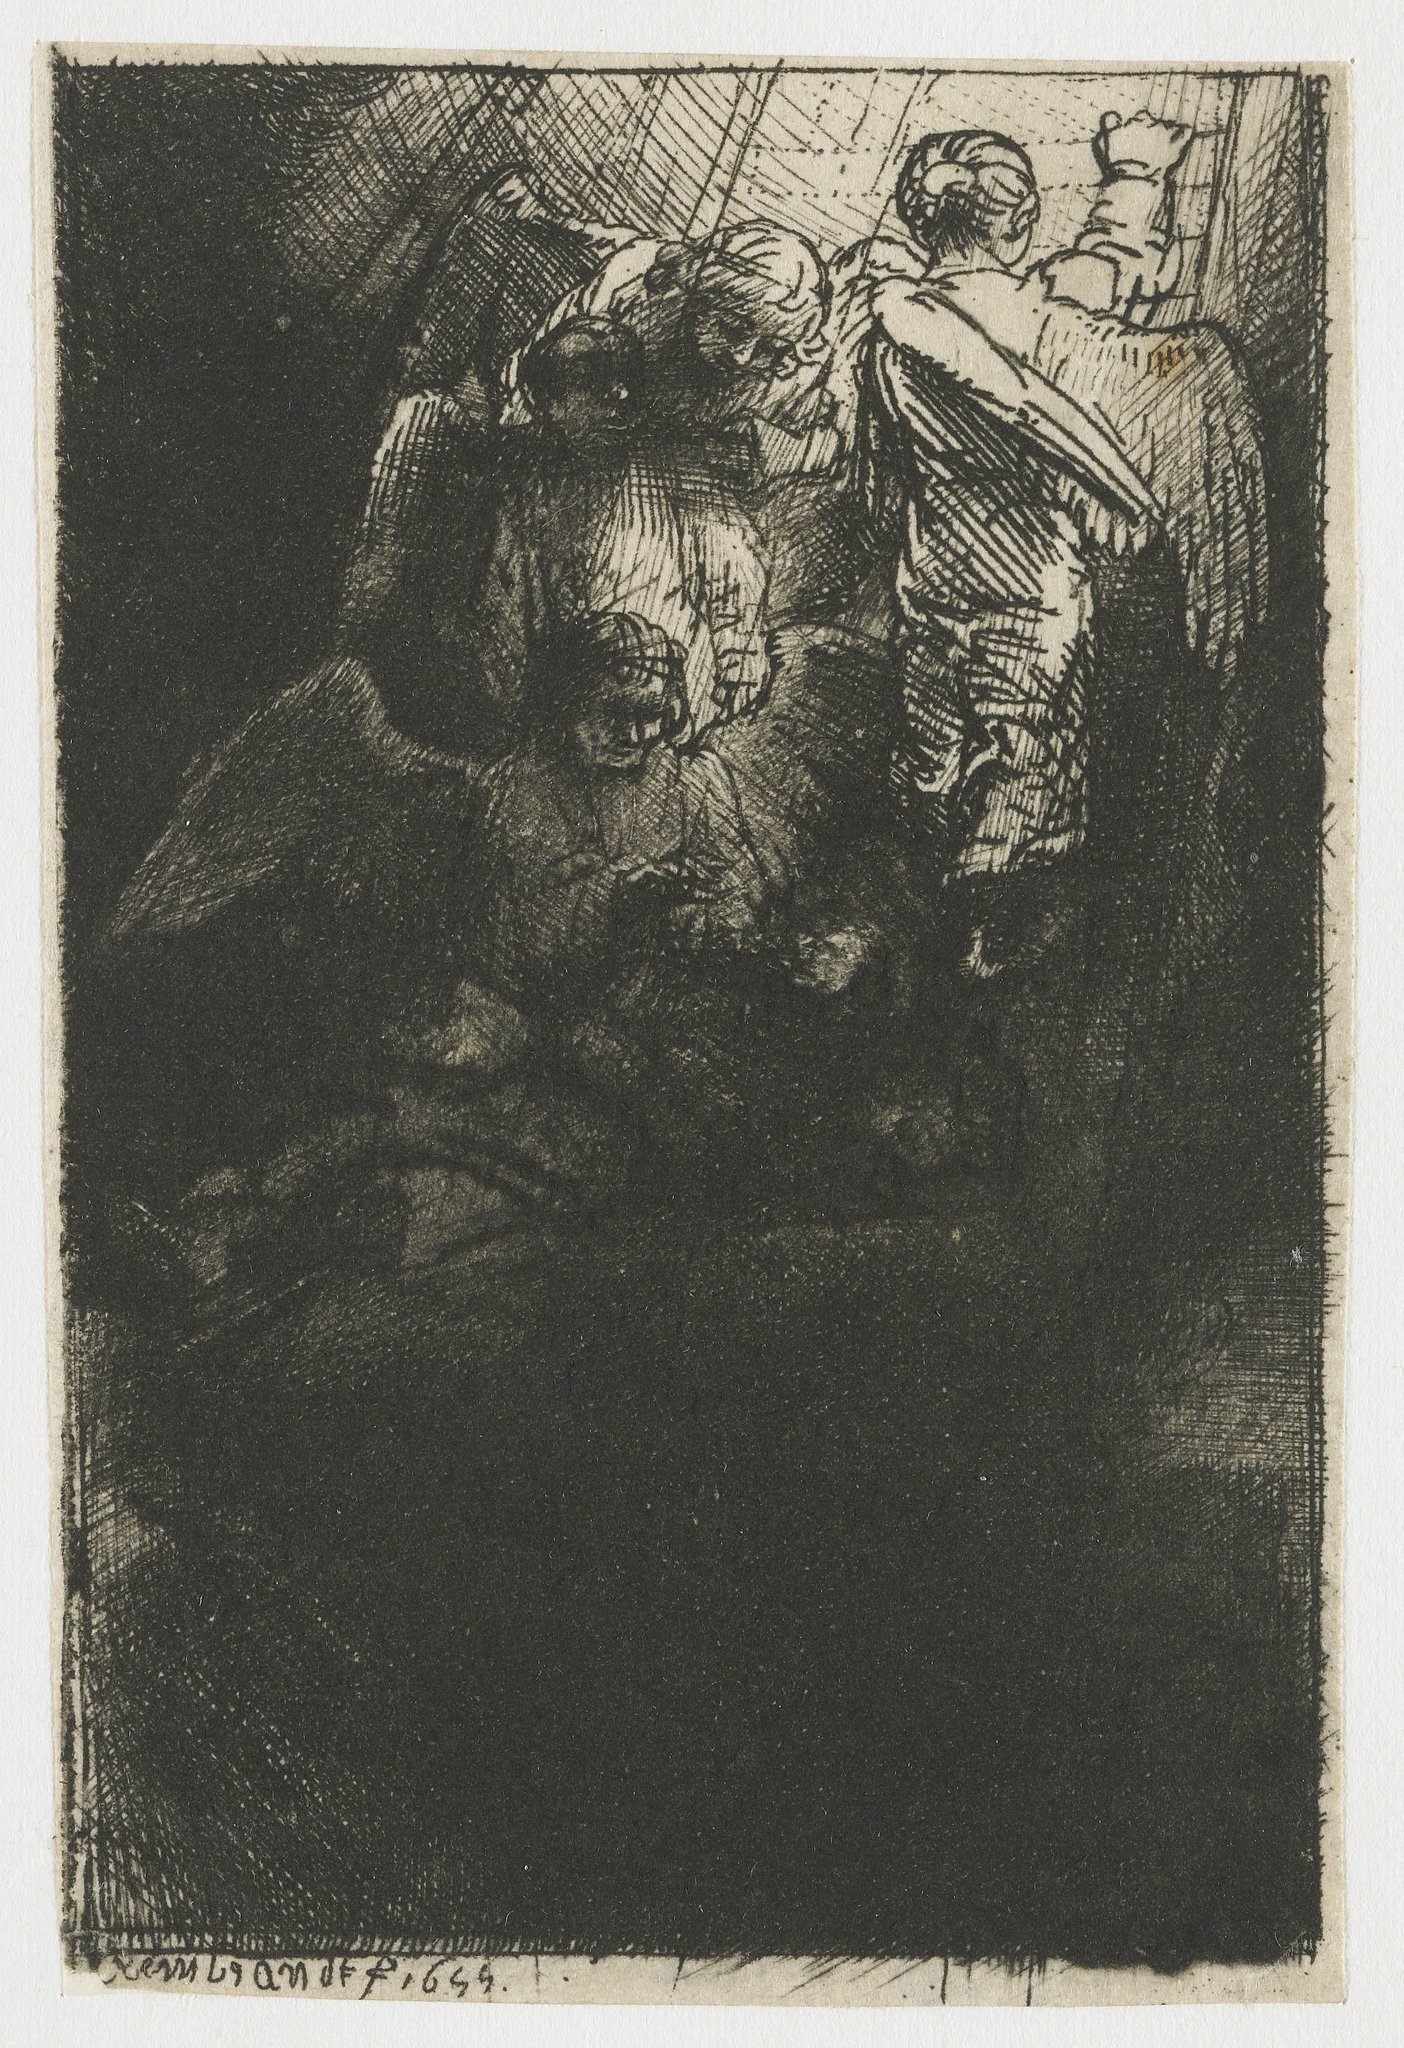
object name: print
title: Jacob's ladder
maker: rembrandt van rijn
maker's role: draughtsman, painter, print maker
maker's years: 1606-1669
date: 1655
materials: paper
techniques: drypoint, etching, intaglio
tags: the dream of jacob: while sleeping on the ground with a stone for pillow jacob sees a ladder reaching from earth to heaven with angels going up and down; usually with god at the top of the ladder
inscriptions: signature and date: ‘Rembrandt f 1655’, collector's mark: Lugt 240